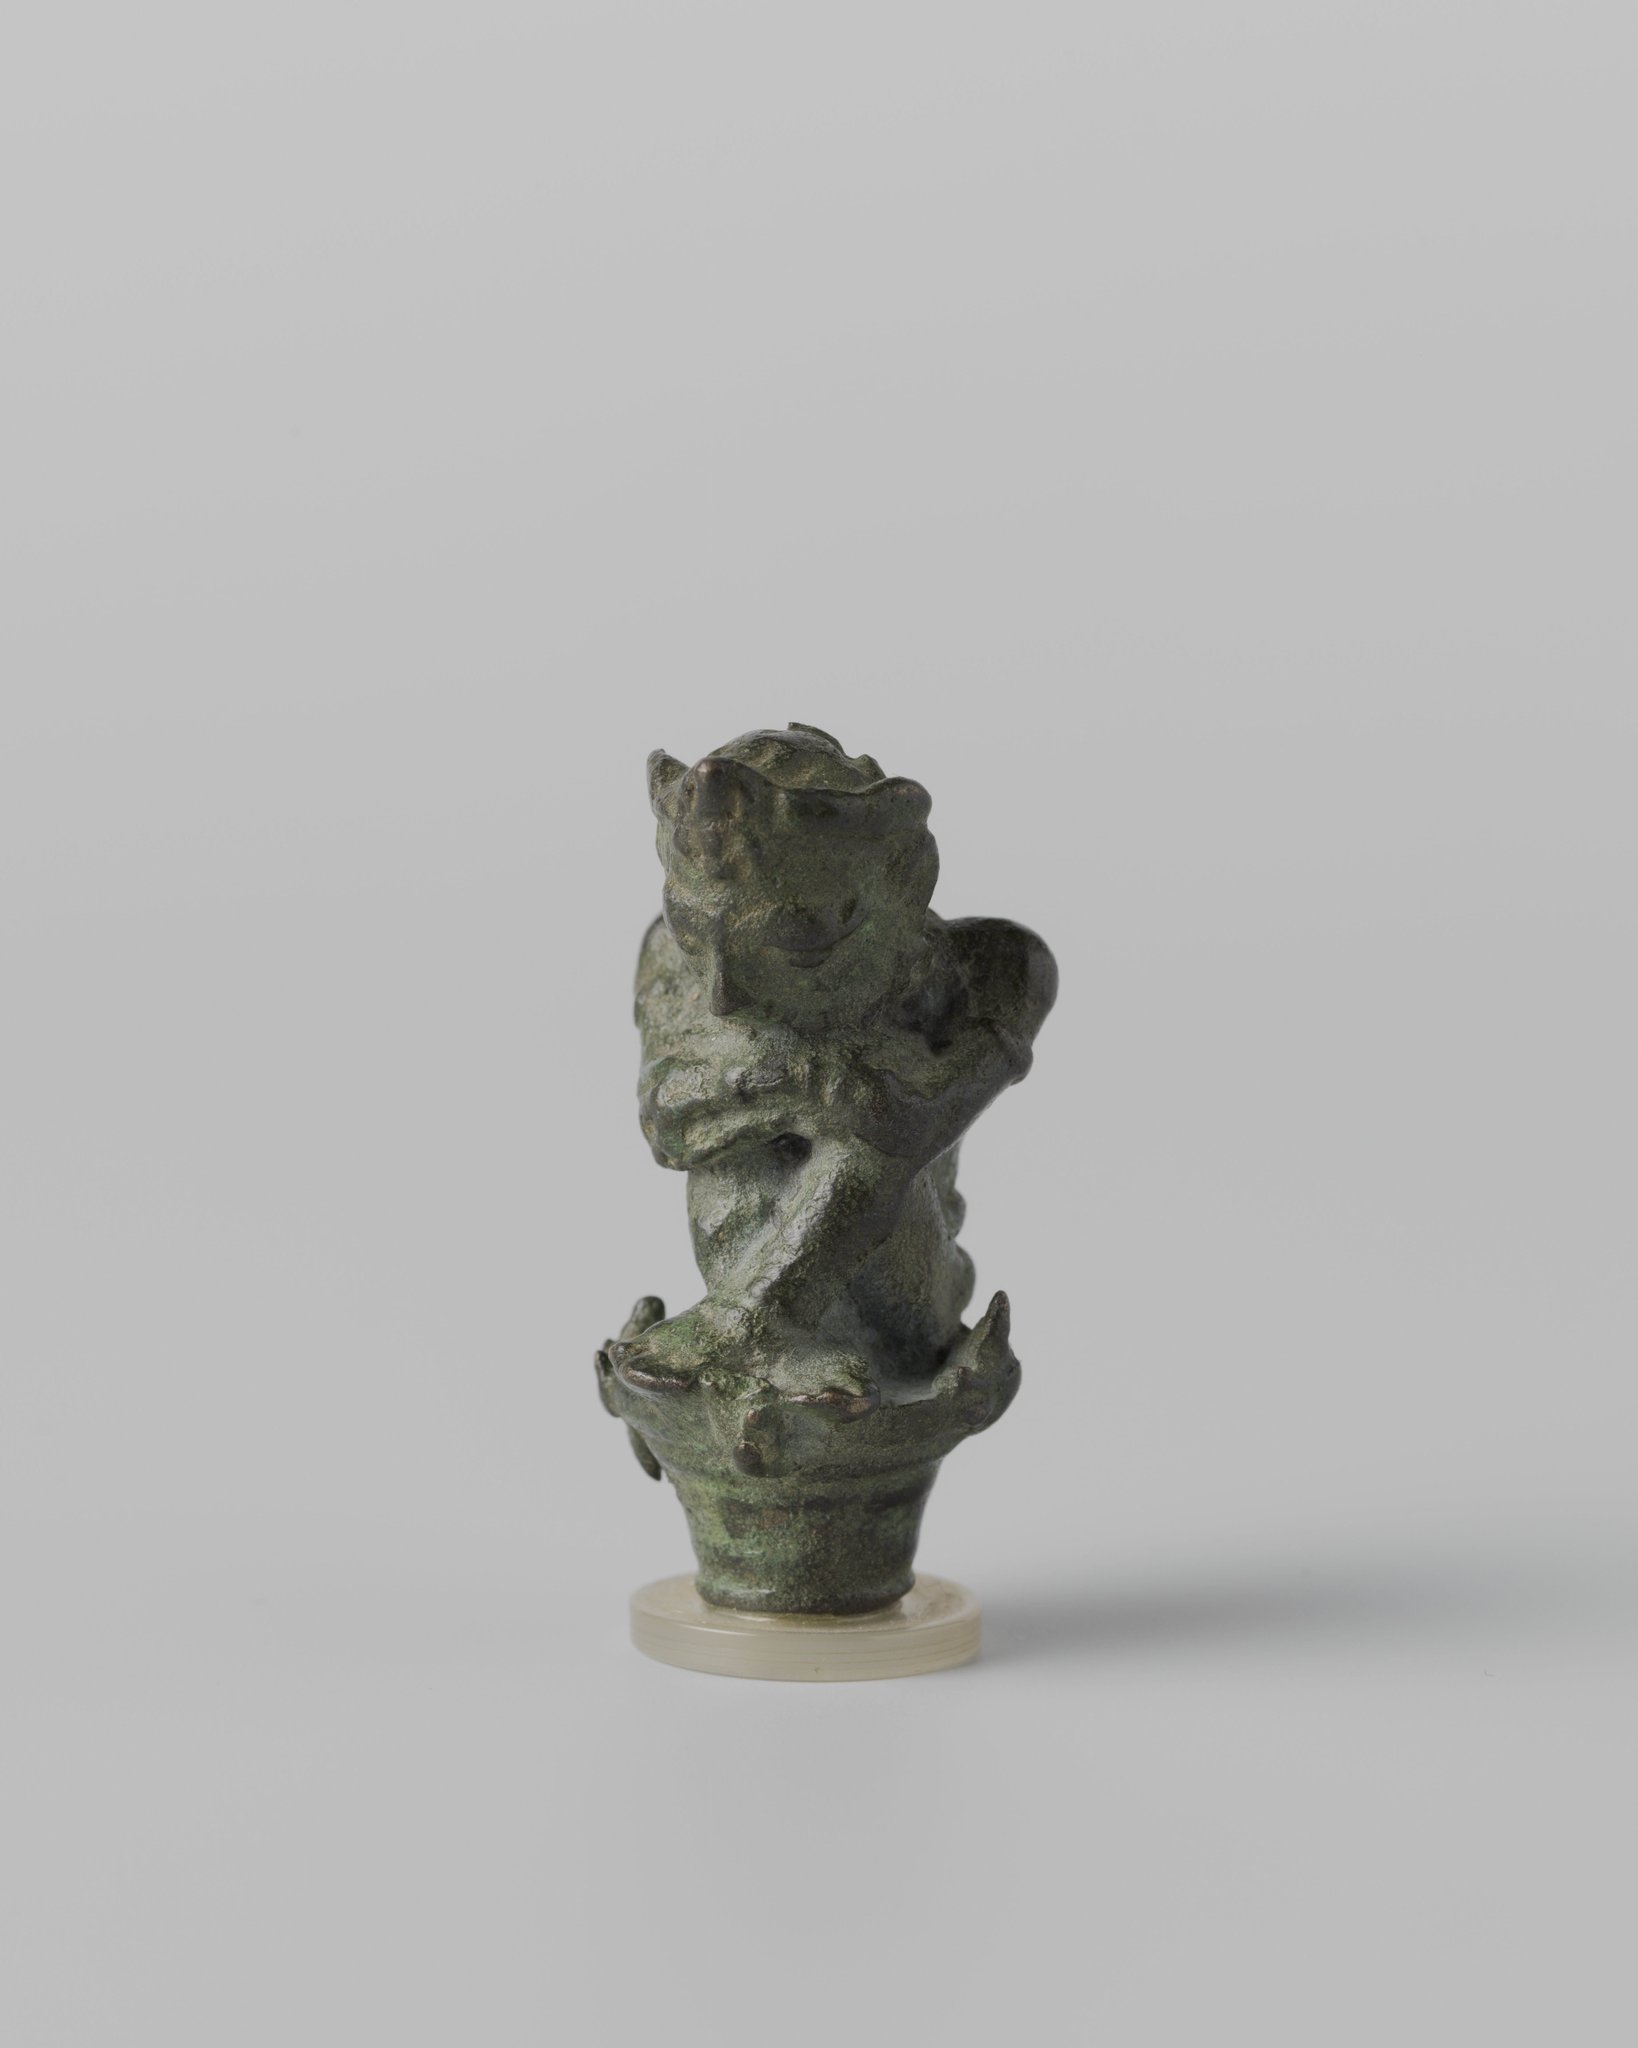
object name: handbell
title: Fragment of a handbell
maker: Anonymous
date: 930-1600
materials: bronze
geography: indonesia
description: Topstuk van een handbel in de vorm van een zittende man met opgetrokken, gekruiste benen. Zittend op rond onderstuk, waarvan rand gedecoreerd met vier floralistische motieven.